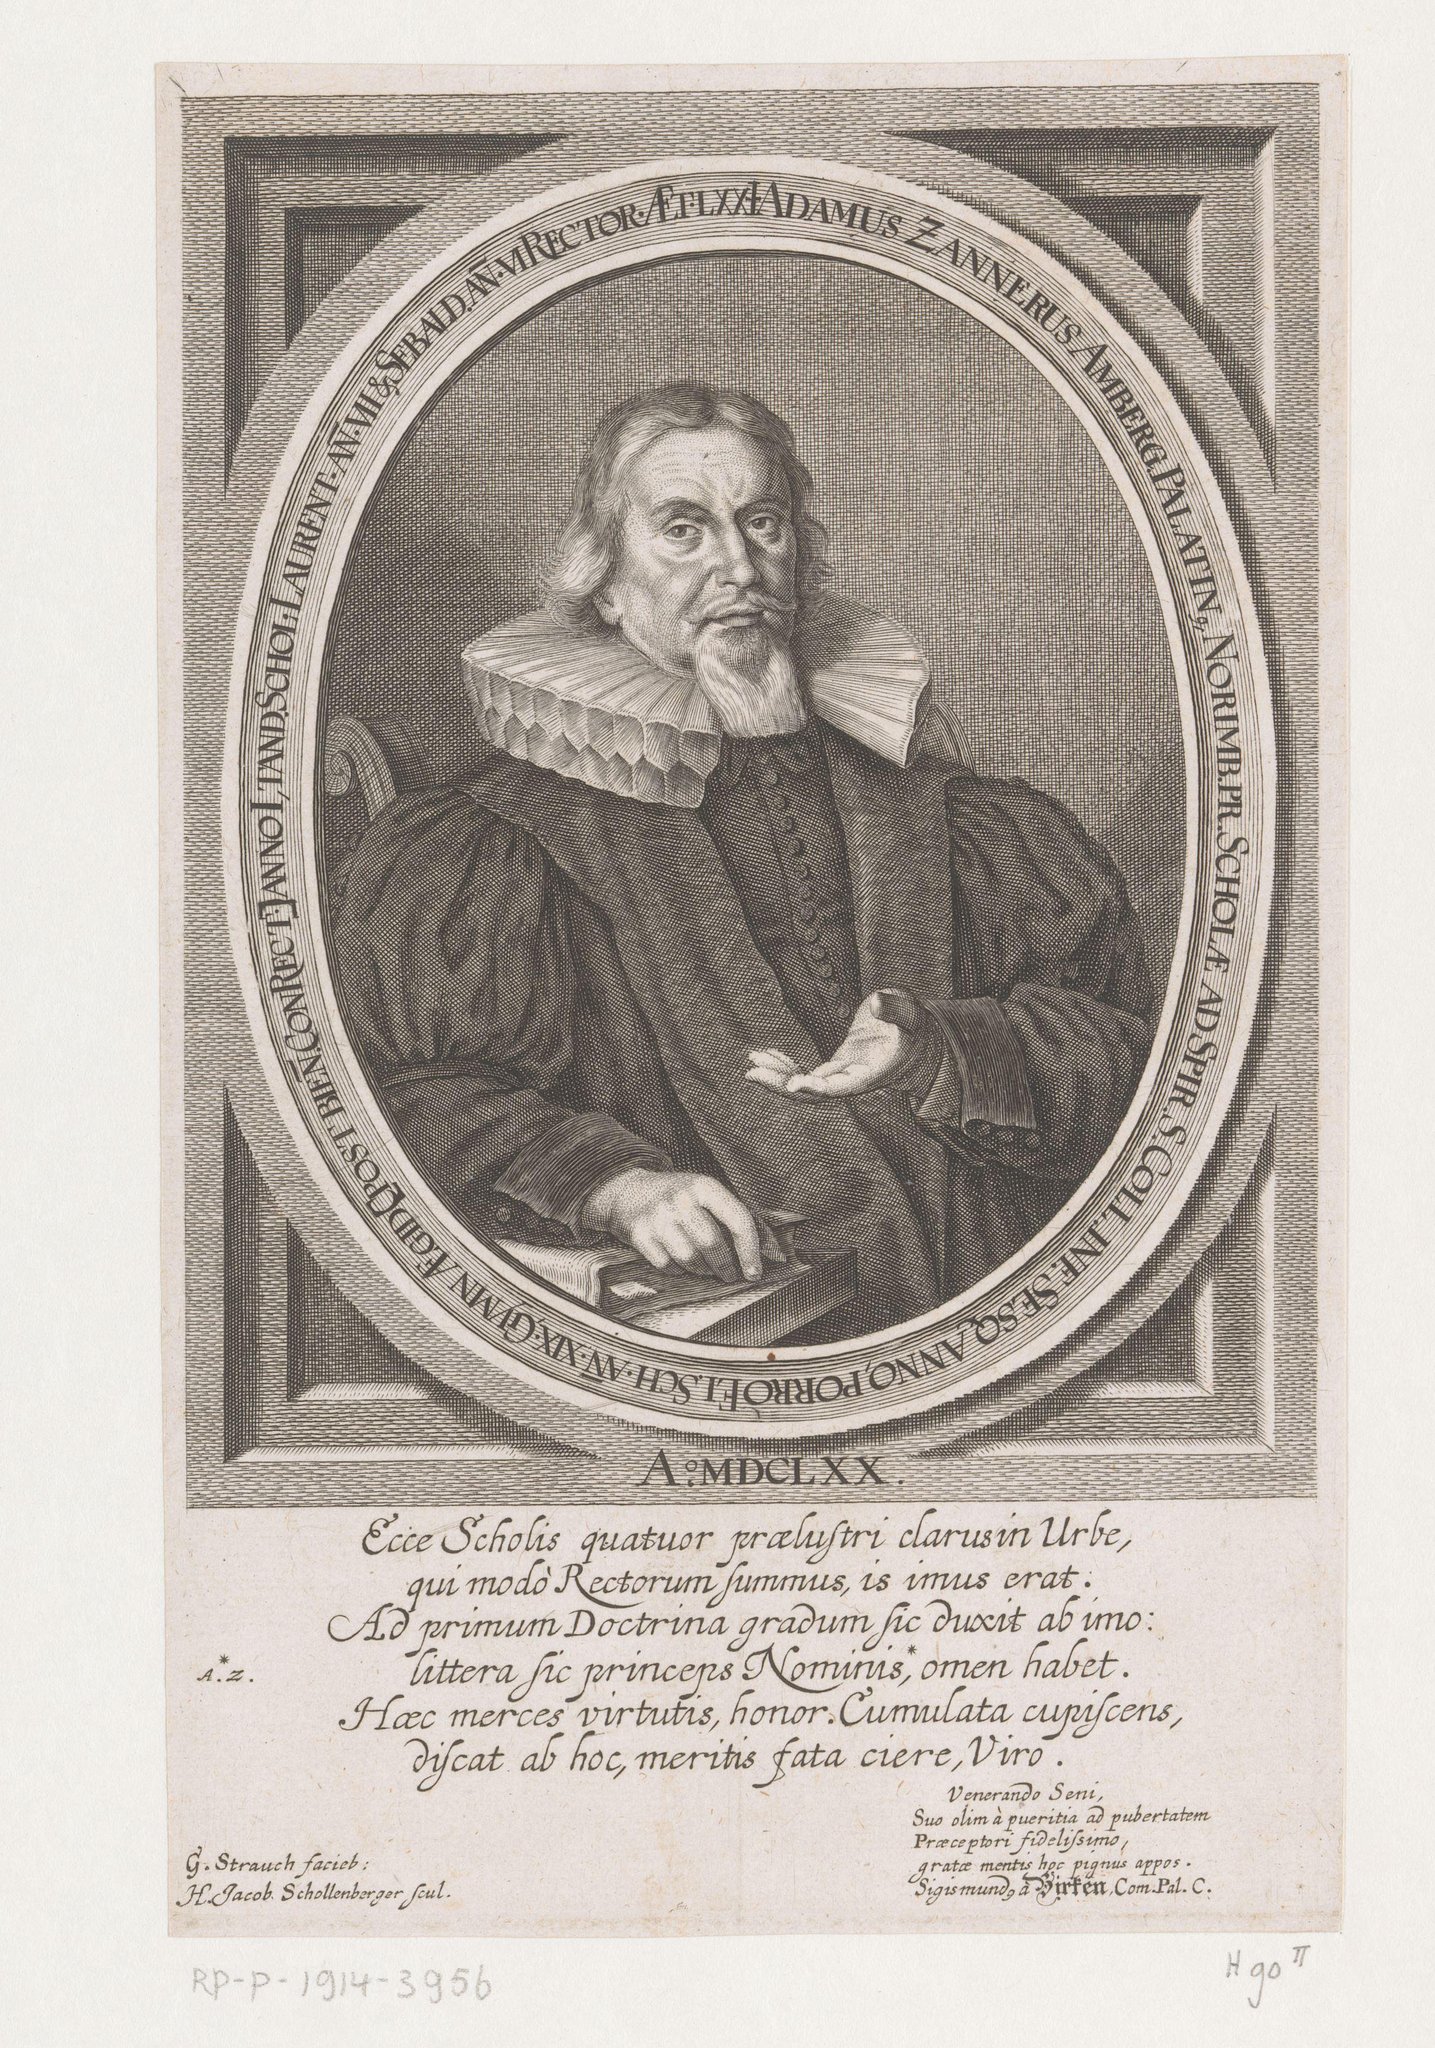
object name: print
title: Portret van Adam Zanner op 70-jarige leeftijd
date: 1670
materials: paper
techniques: engraving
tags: publisher, adam zanner, publishing, publisher (+ portrait of scholar, scientist), historical persons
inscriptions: collector's mark: Lugt 2228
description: Tekst in het Latijn in de omlijsting en in de ondermarge.